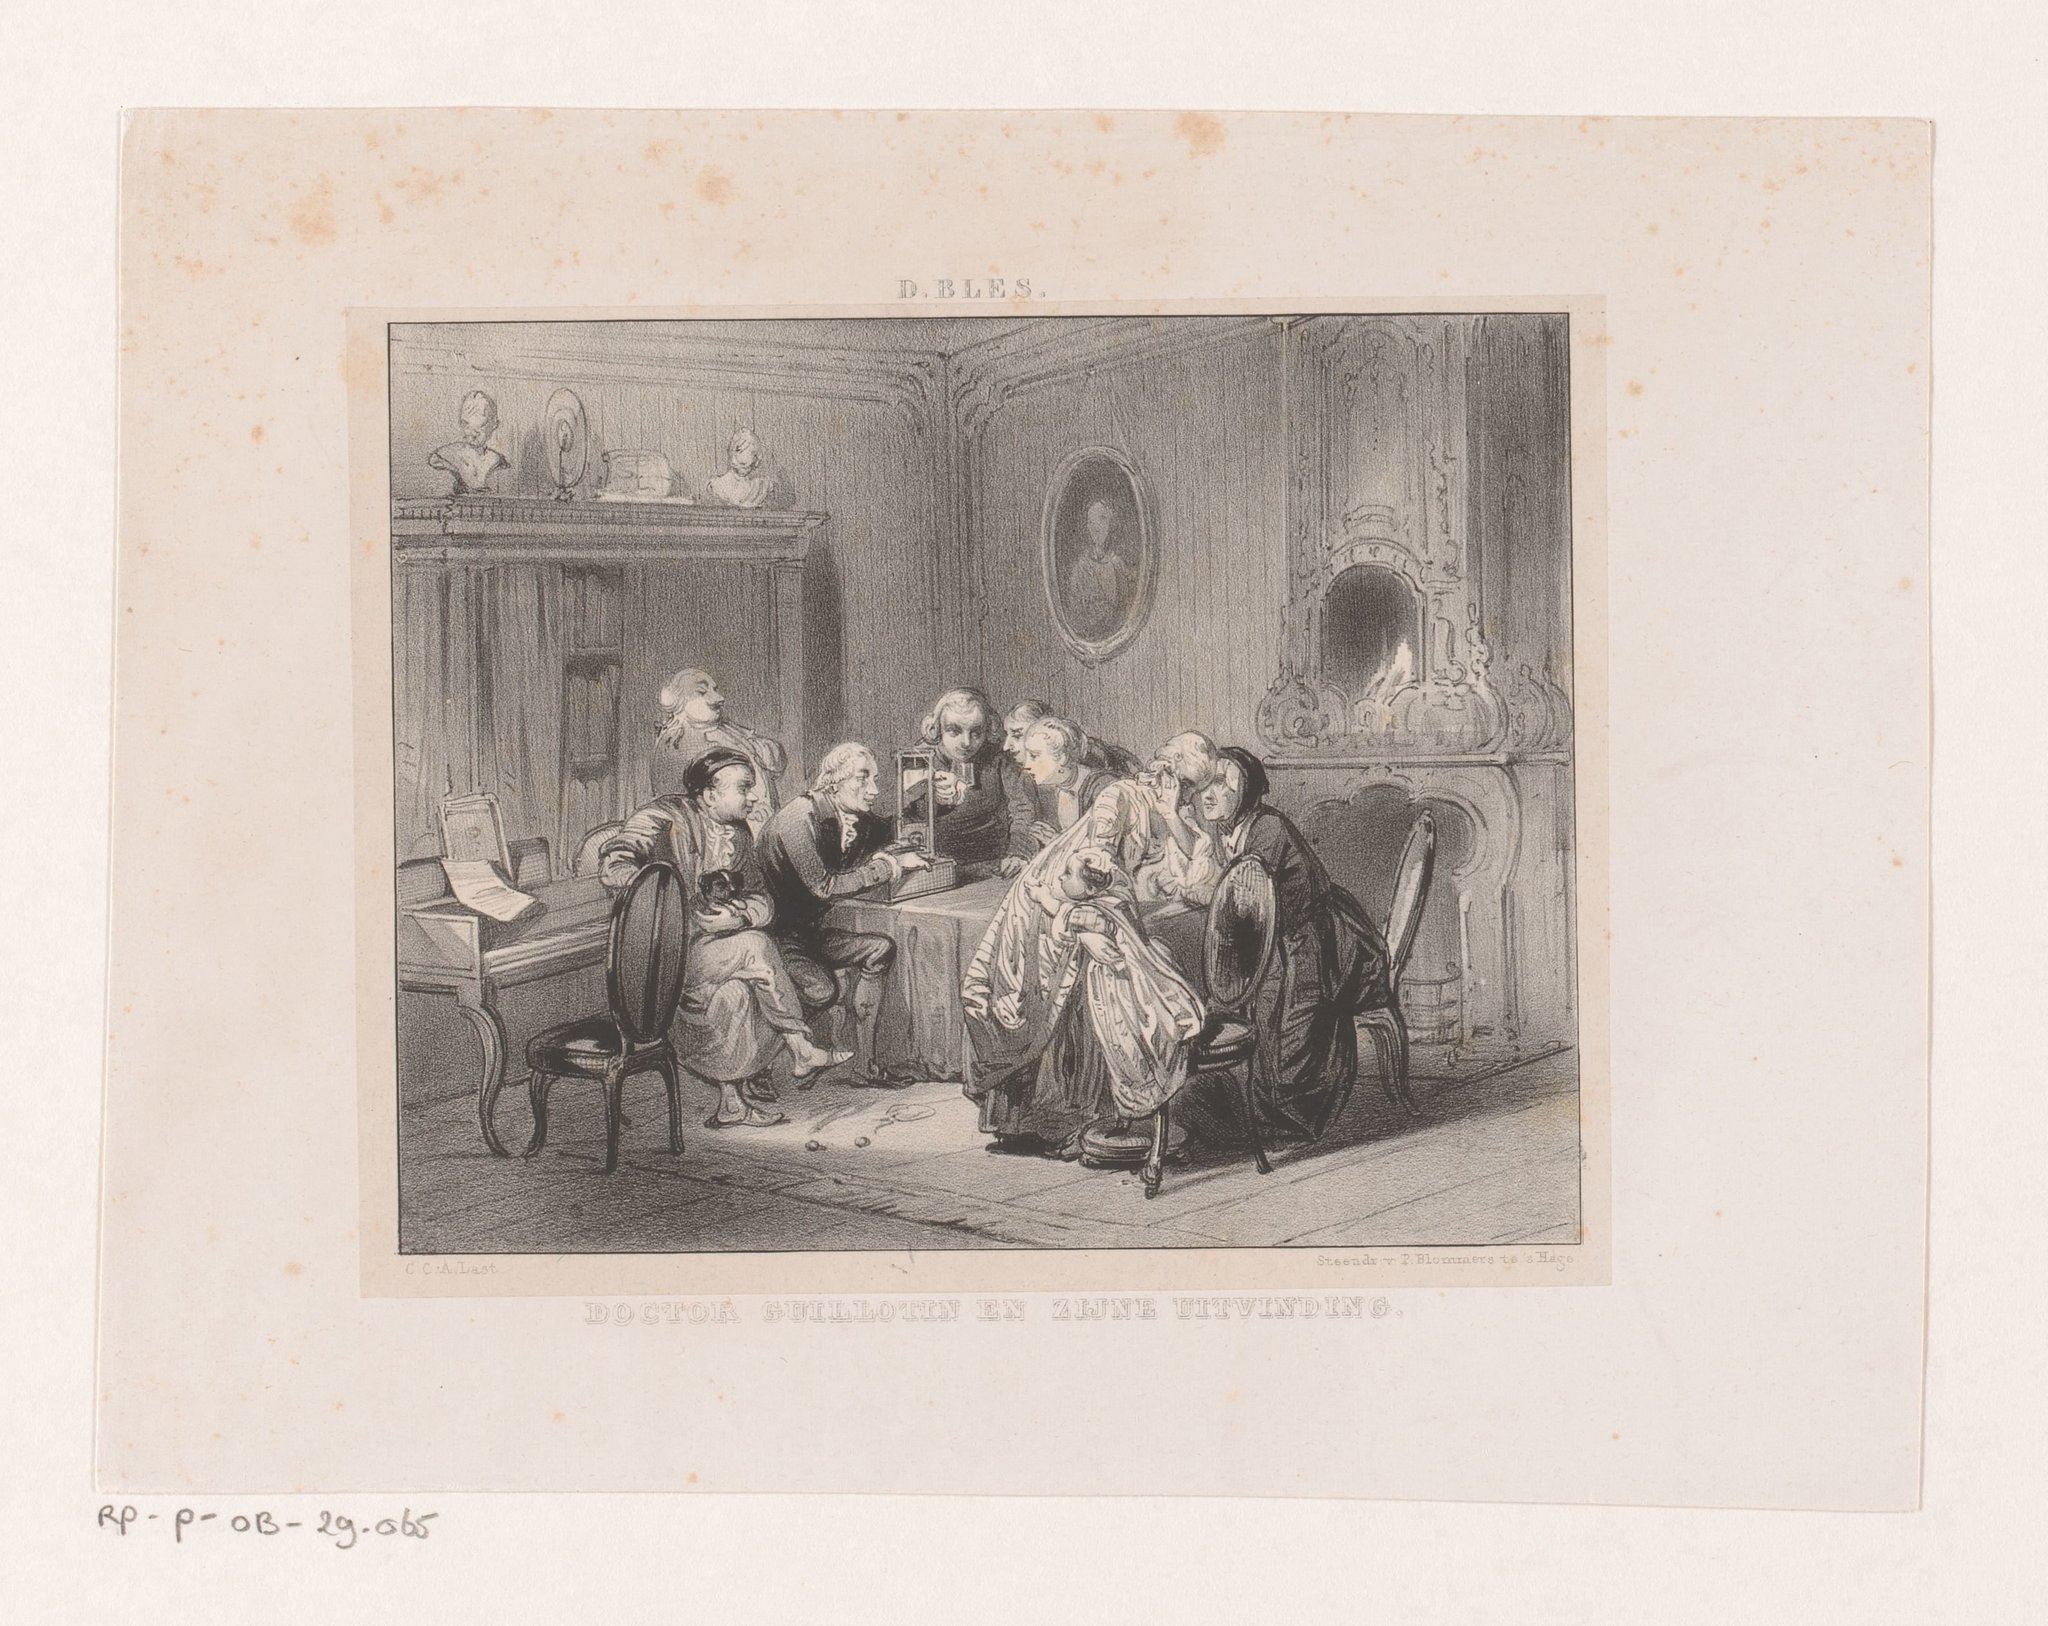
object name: print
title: Doctor Guillotin en zijne uitvinding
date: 1842-1887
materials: paper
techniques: lithograph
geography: the hague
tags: violent death ~ beheading by guillotine, invention, discovery ~ science and technology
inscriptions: collector's mark: Lugt 2228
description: Een gezelschap, waaronder Joseph-Ignace Guillotin, zit aan tafel en bekijkt een miniatuur versie van de guillotine.